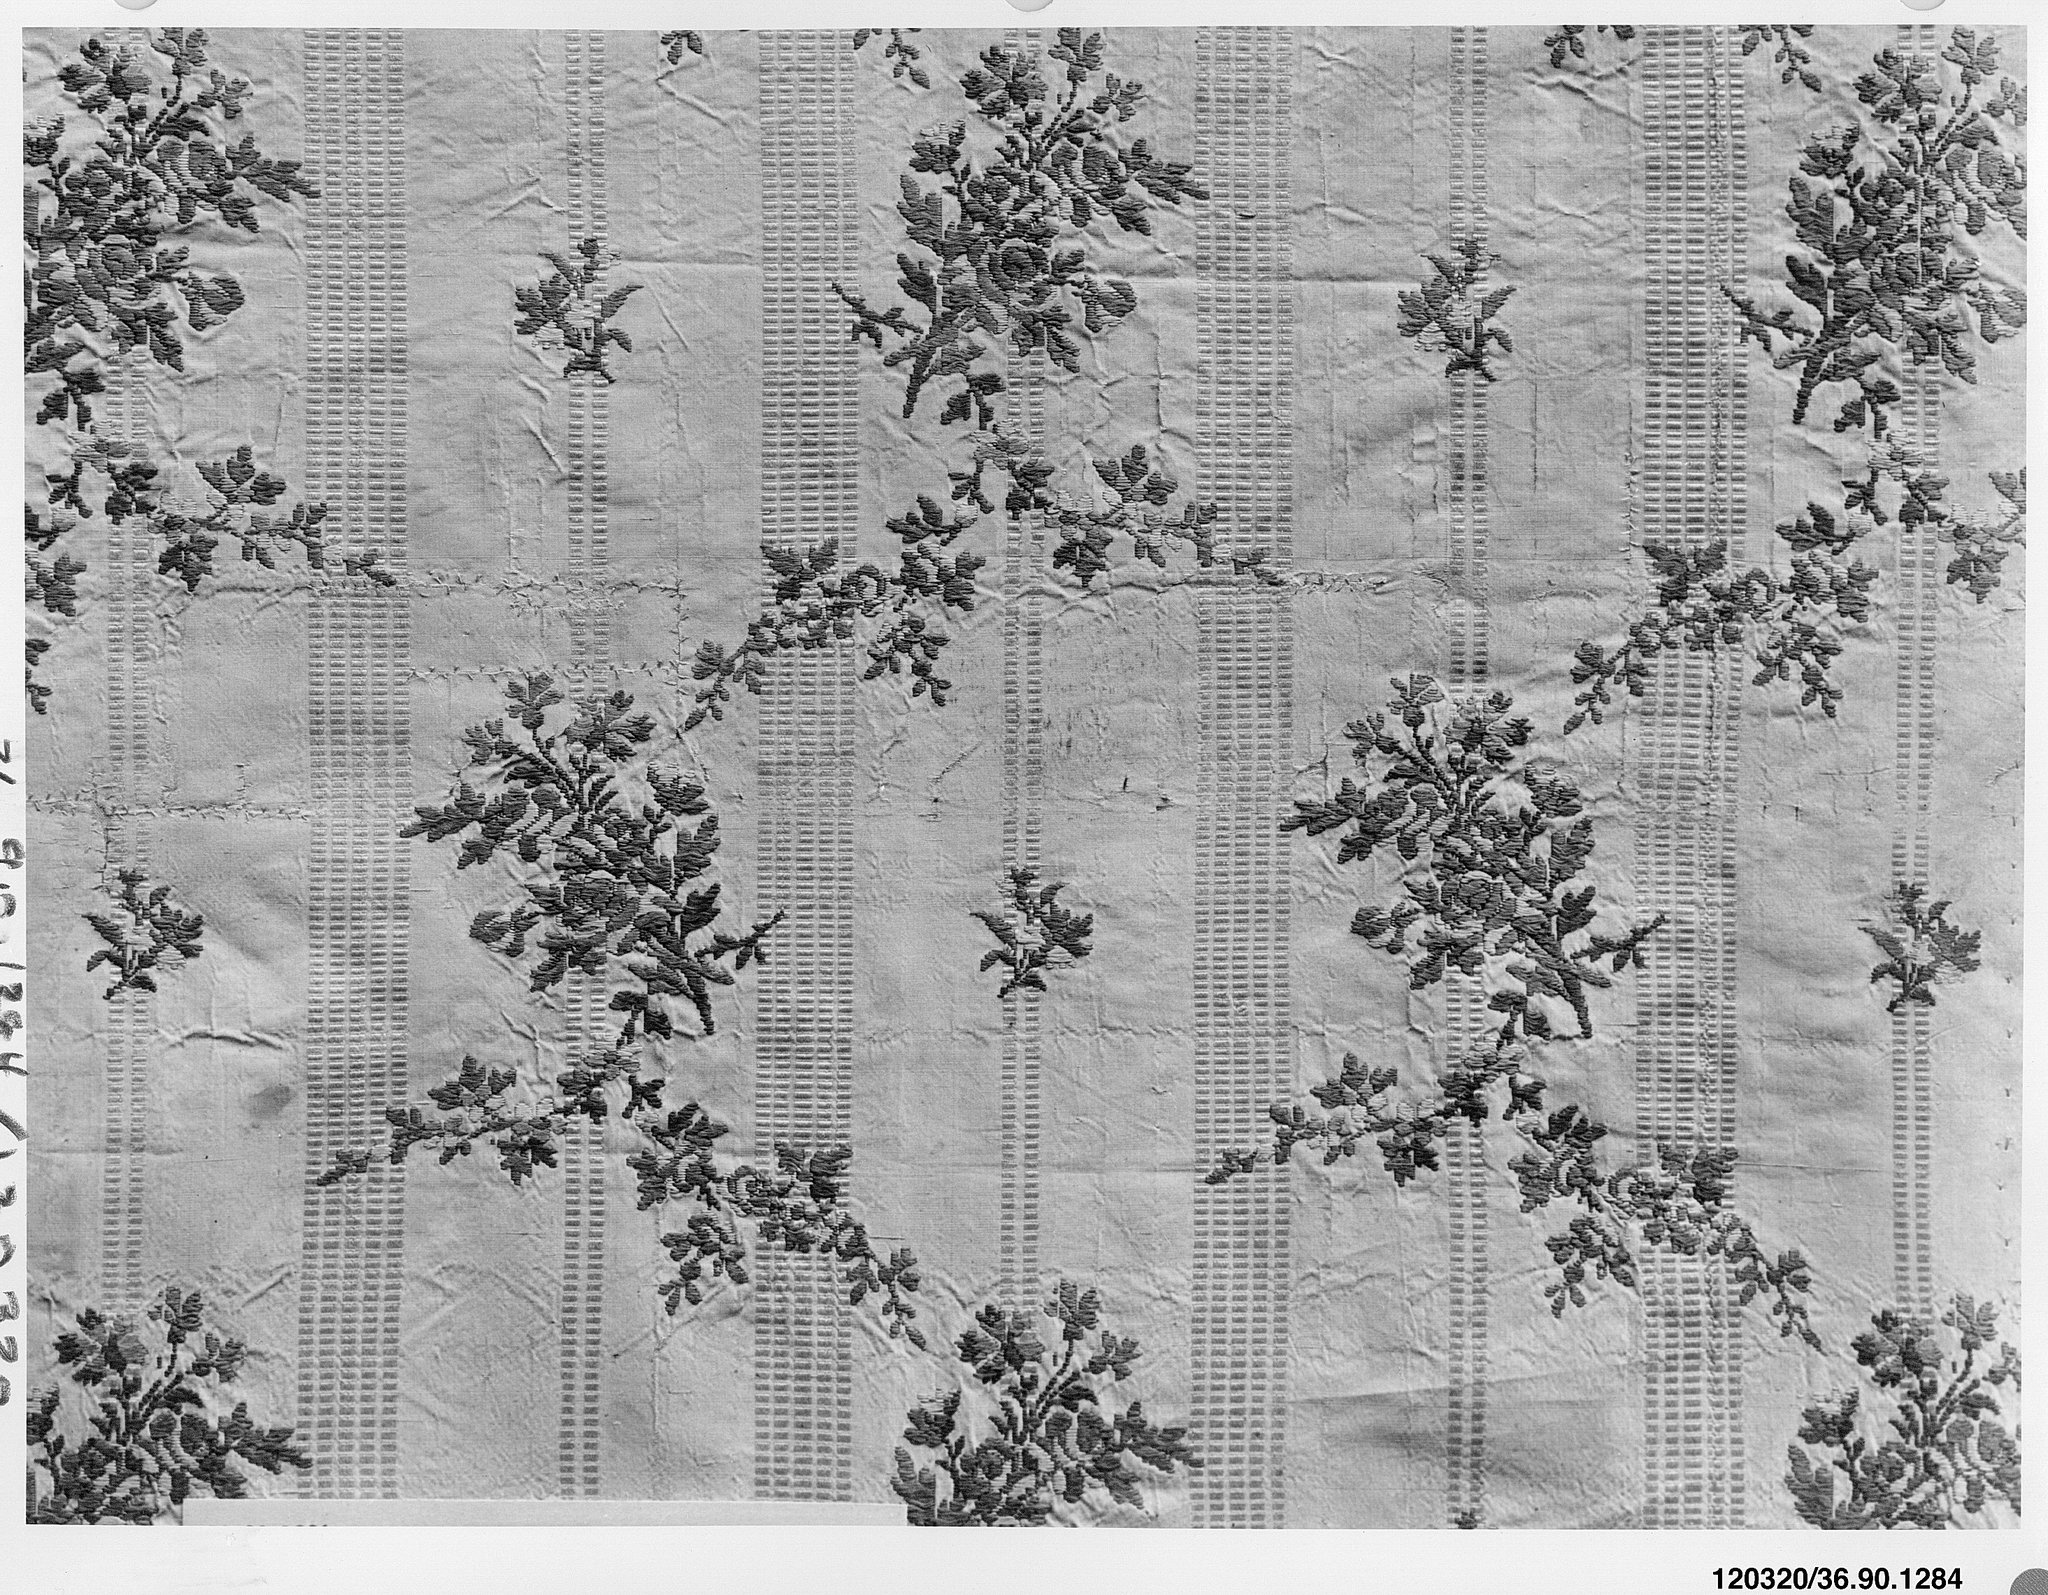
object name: piece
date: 1701-1800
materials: silk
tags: flowers,leaves